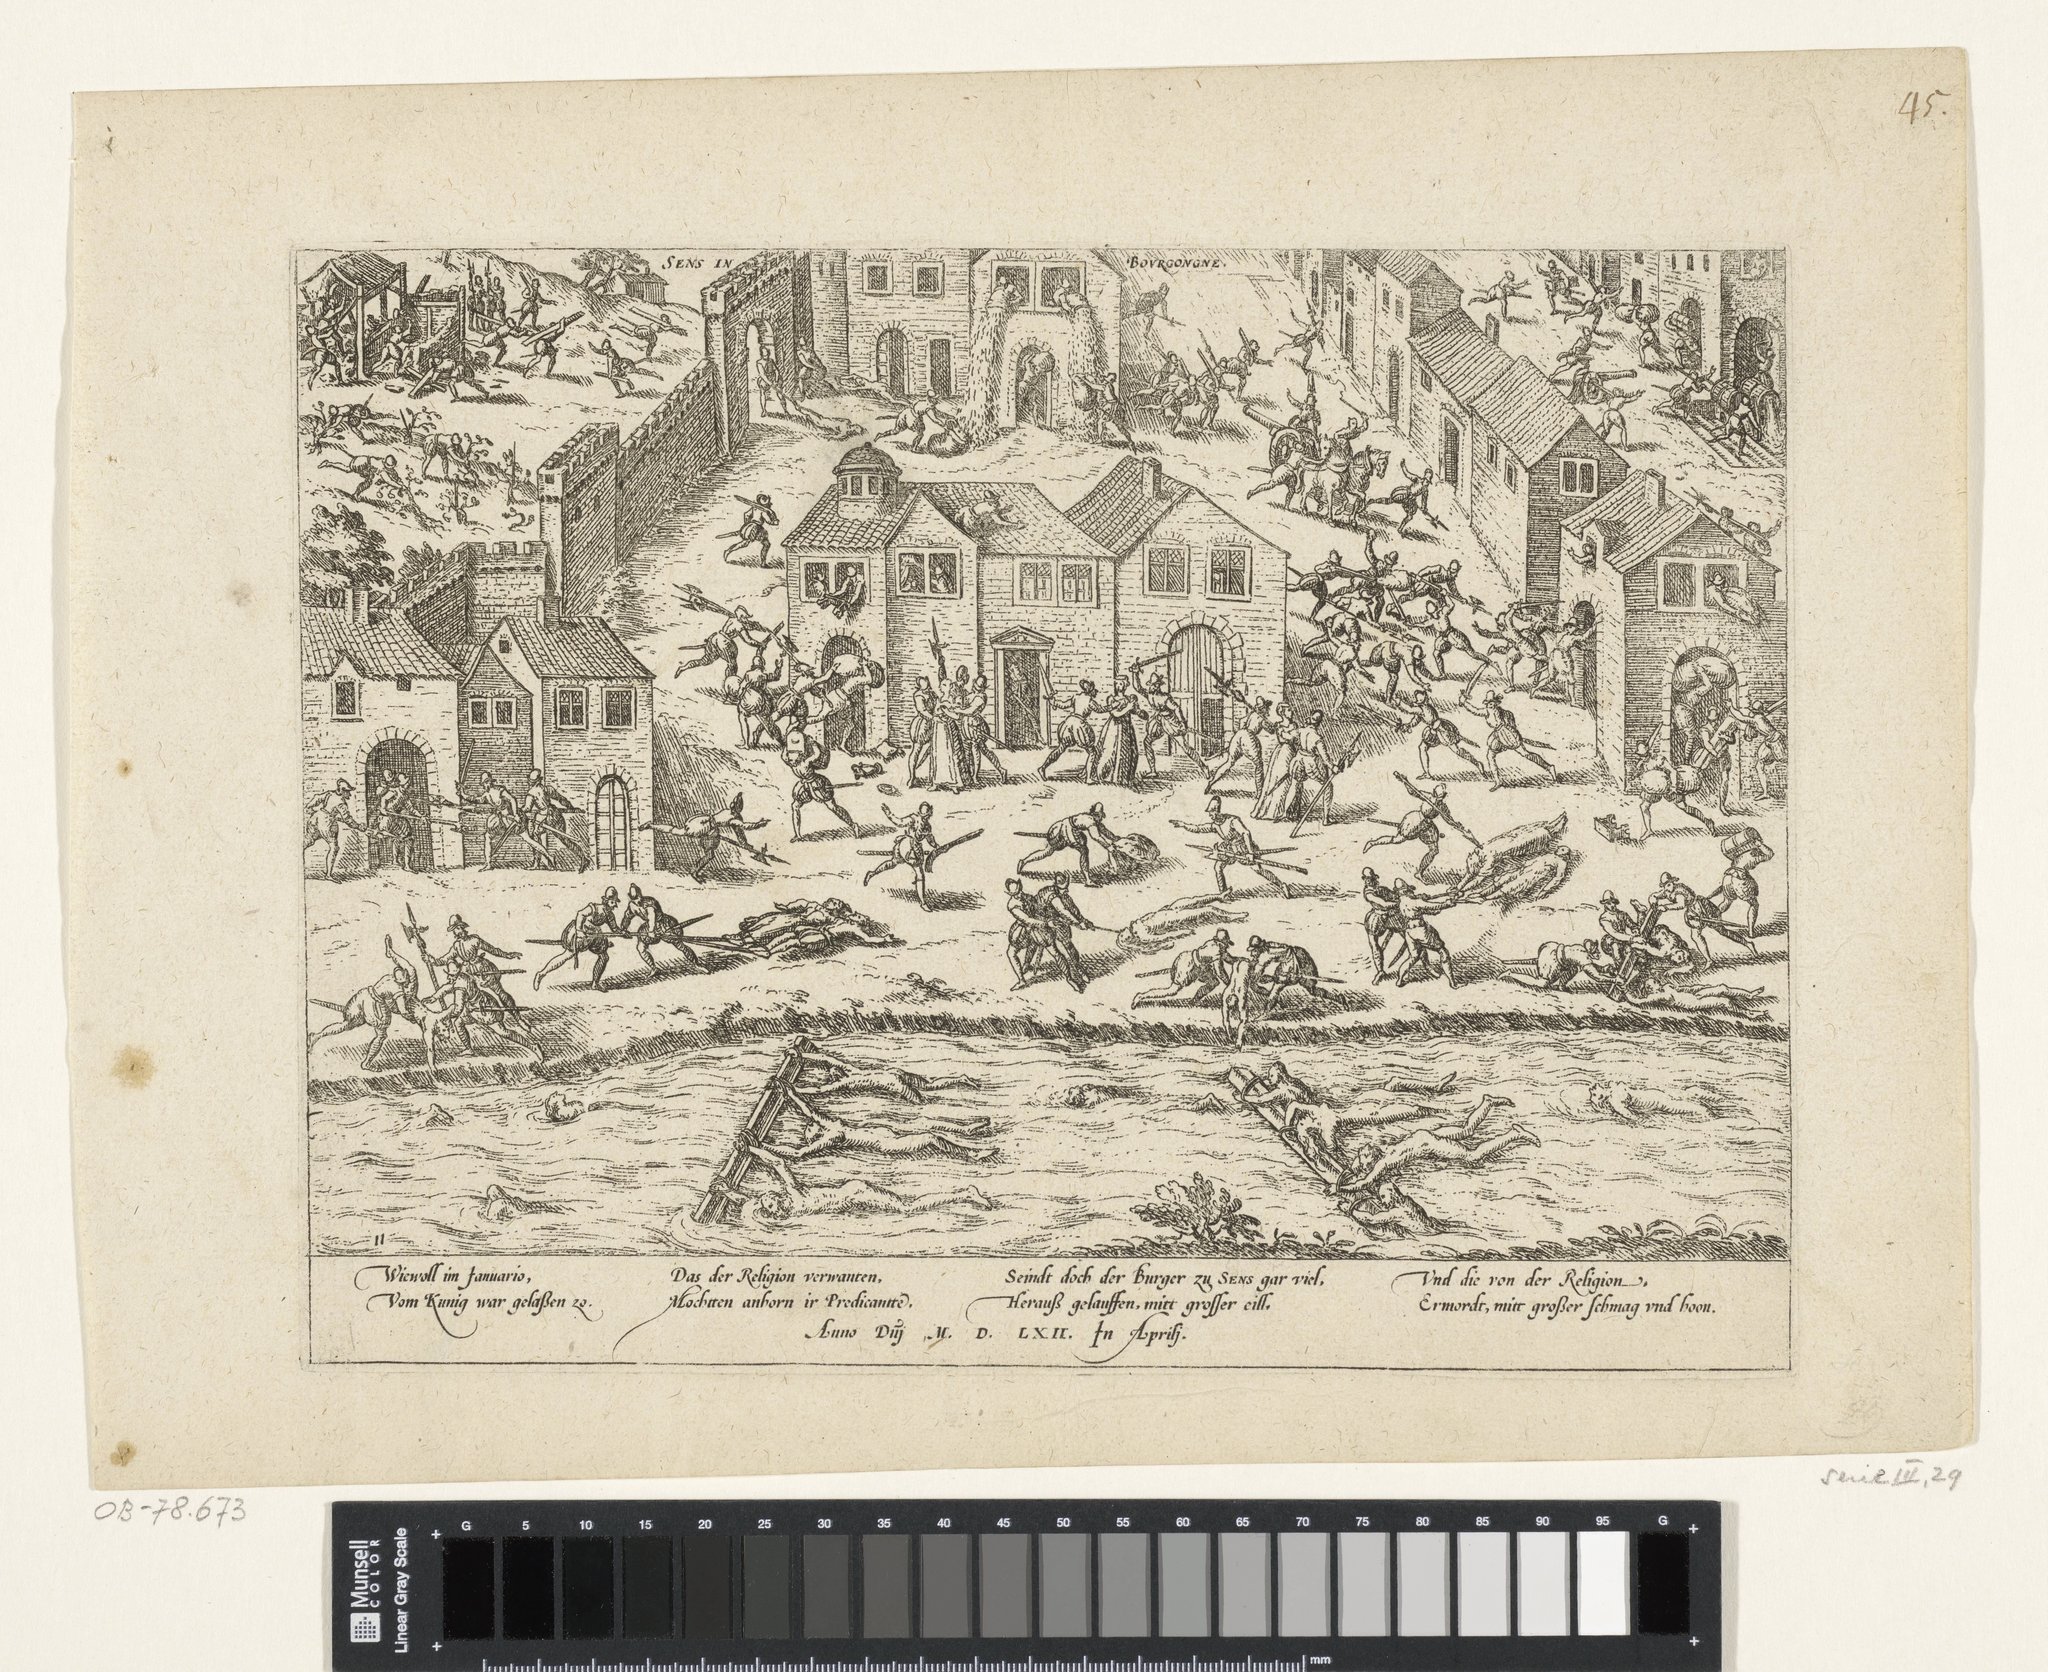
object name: history print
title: Serie 3: Franse Godsdienstoorlogen, 1559-1573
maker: frans hogenberg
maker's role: print maker, publisher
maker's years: 1538-1590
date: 1565-1573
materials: paper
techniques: etching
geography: cologne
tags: massacre ~ war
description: Gekopieerd naar de prent in: Jean Tortorel et Jacques Perrissin, Premier volume contenant quarante tableaux ou Histoires diverses qui sont memorables touchant les Guerres, Massacres et Troubles advenus en France en ces dernieres annees : le tout recueilly selon le tesmoignange de ceux qui y ont esté en personne et qui les ont veus : lesquels sont pourtraits à la vérité, Genève ca. 1570. Bibliotheek Rijksmuseum: 329 A 2, pl. 12.